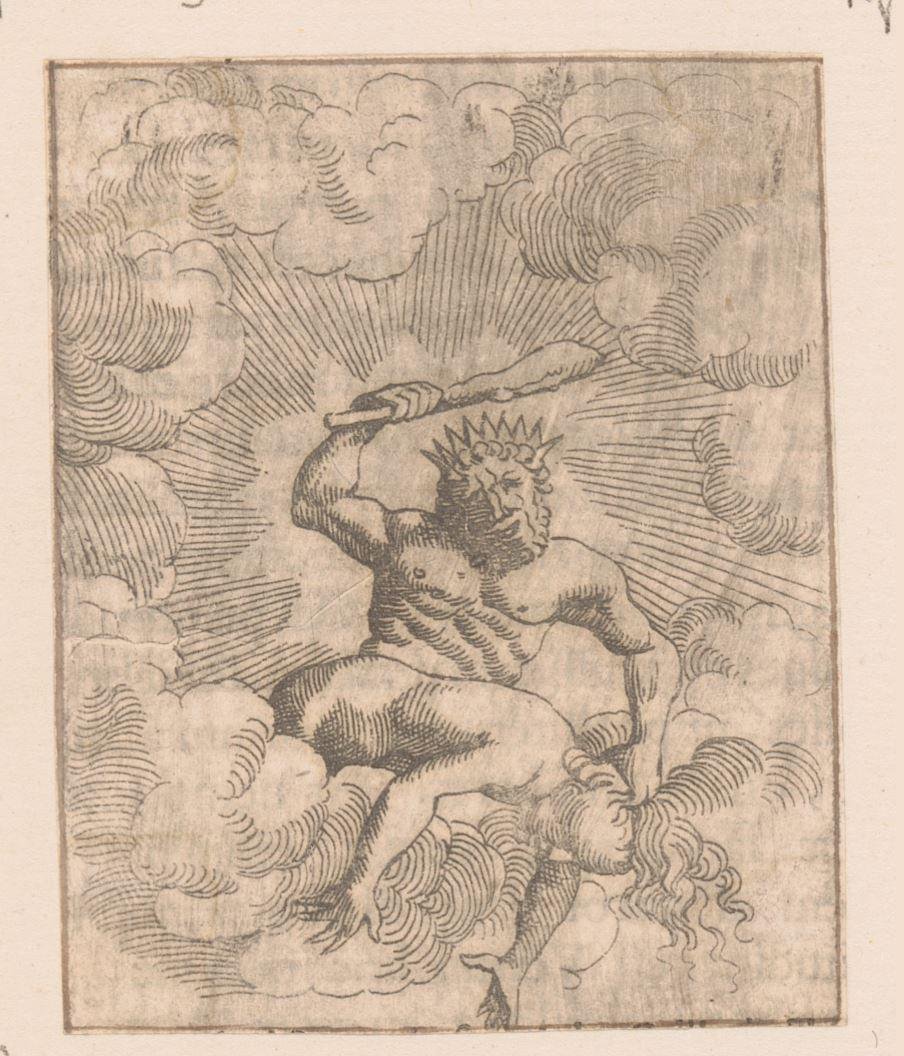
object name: print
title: Jupiter slaat Ate met een knuppel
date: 1516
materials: paper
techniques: etching, letterpress printing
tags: jupiter seizes ate by her hair and hurls her down from olympus, possibly because of the delayed birth of hercules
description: Prent afkomstig uit: Erasmus, Desiderius. Morias enkomion (...). Bazel: Johann Rudolf Genath, 1676. De prenten hierin zijn naar tekeningen die Hans en Ambrosius Holbein maakten voor de theoloog Oswald Myconius in diens uitgave van de Moriae encomium (Lof der Zotheid) van 1516.